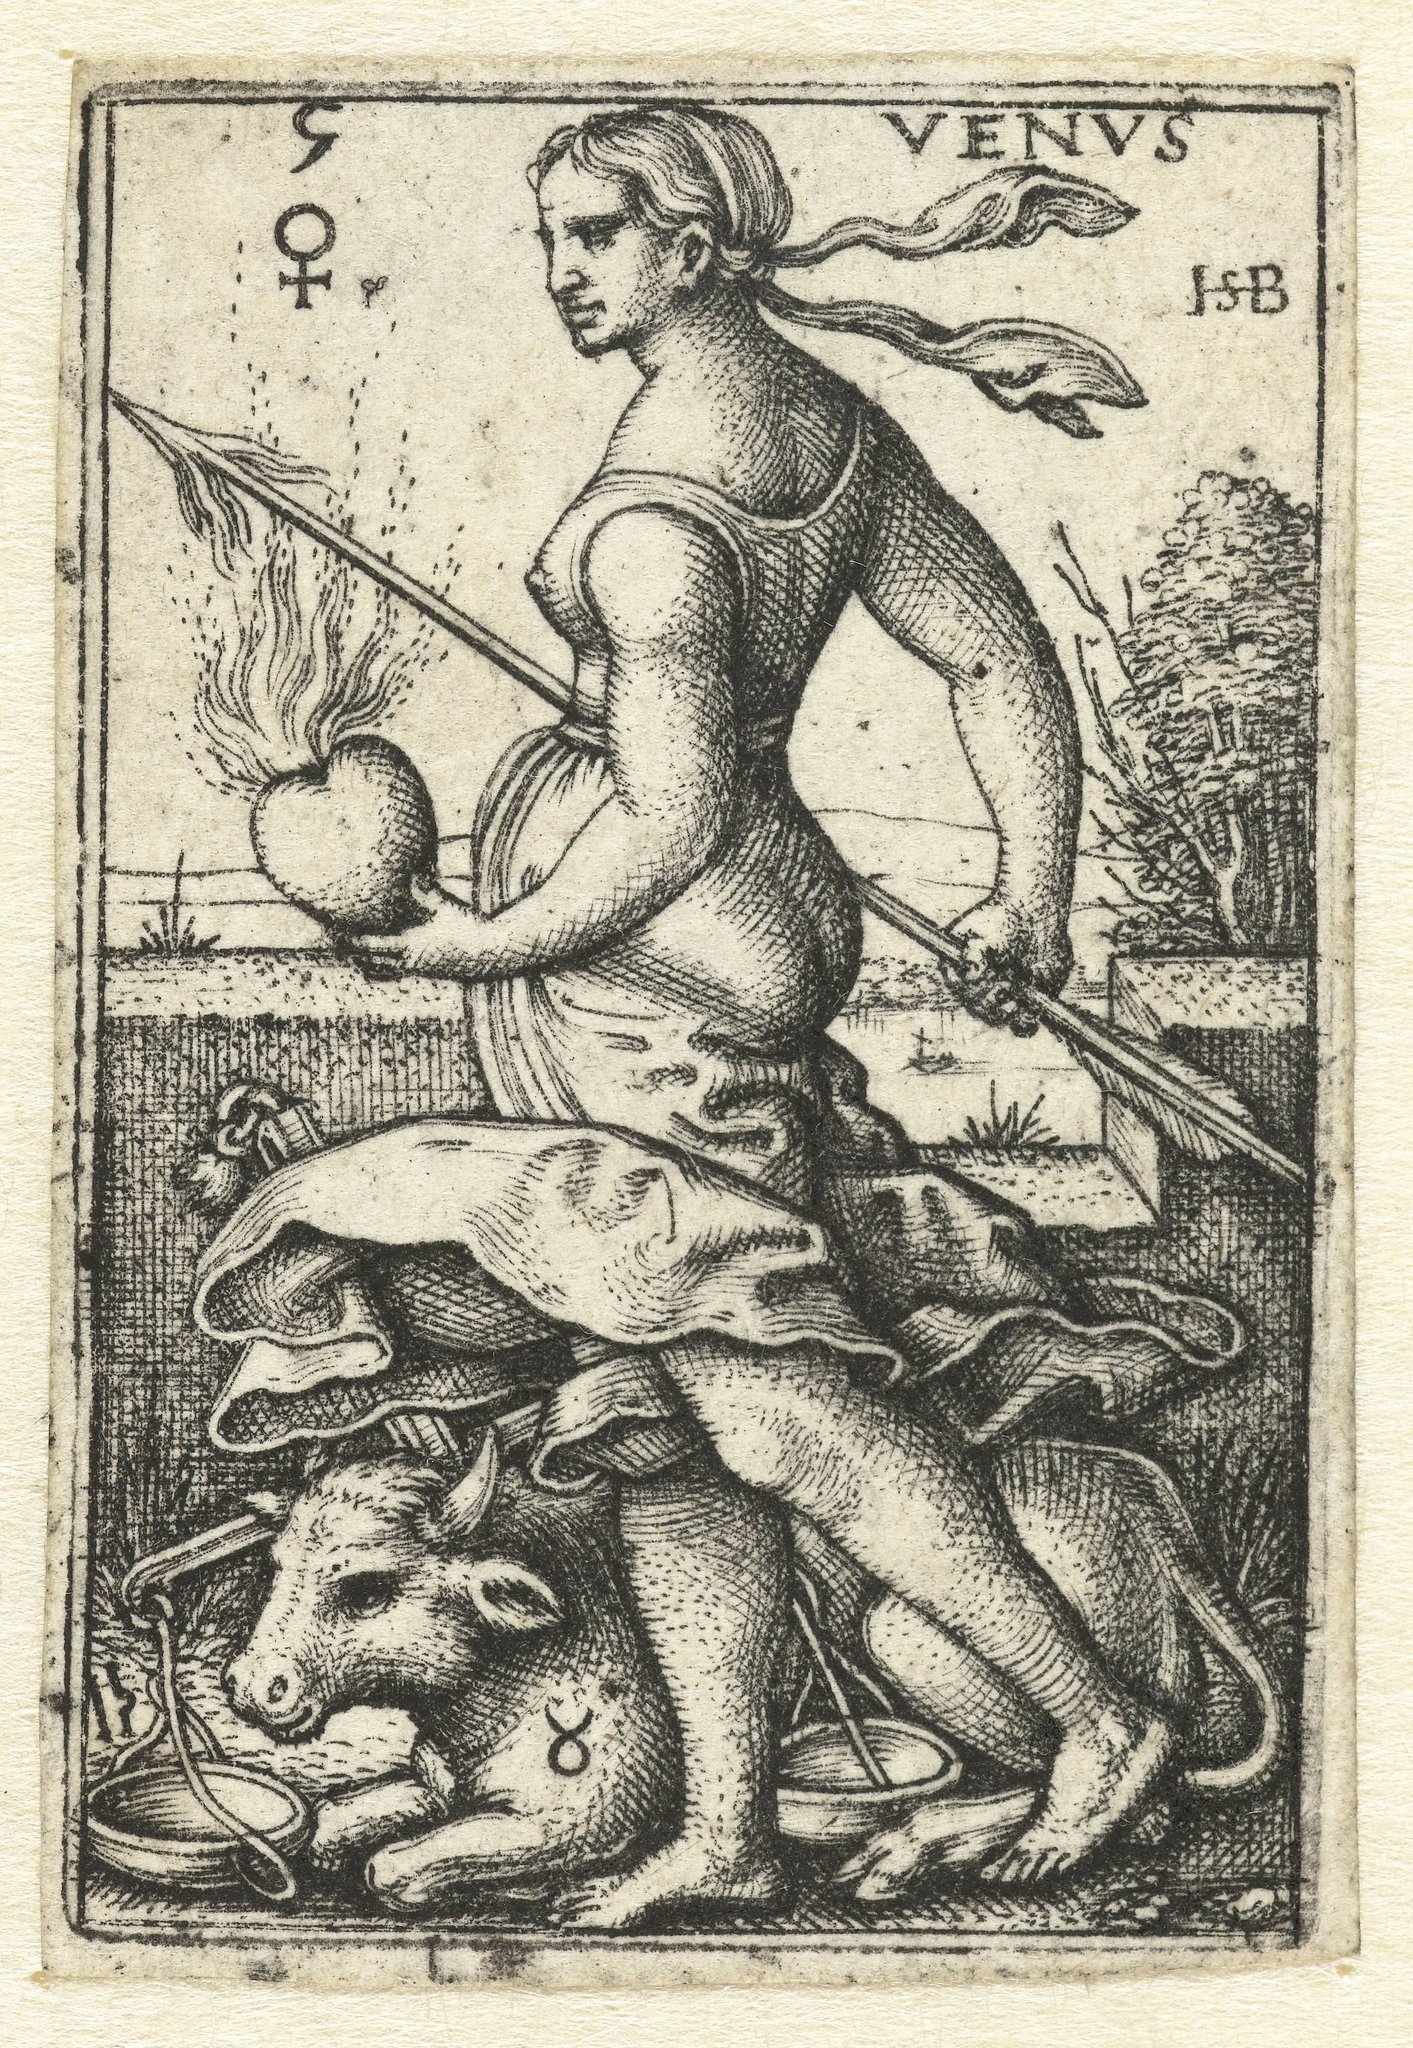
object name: print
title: Zeven planeten en sterrenbeelden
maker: hans sebald beham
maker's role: designer, draughtsman, print maker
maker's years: 1500-1550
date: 1539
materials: paper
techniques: engraving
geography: frankfurt am main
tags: venus and her children ('planetenkinder') ~ taurus and libra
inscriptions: collector's mark: Lugt 2228a